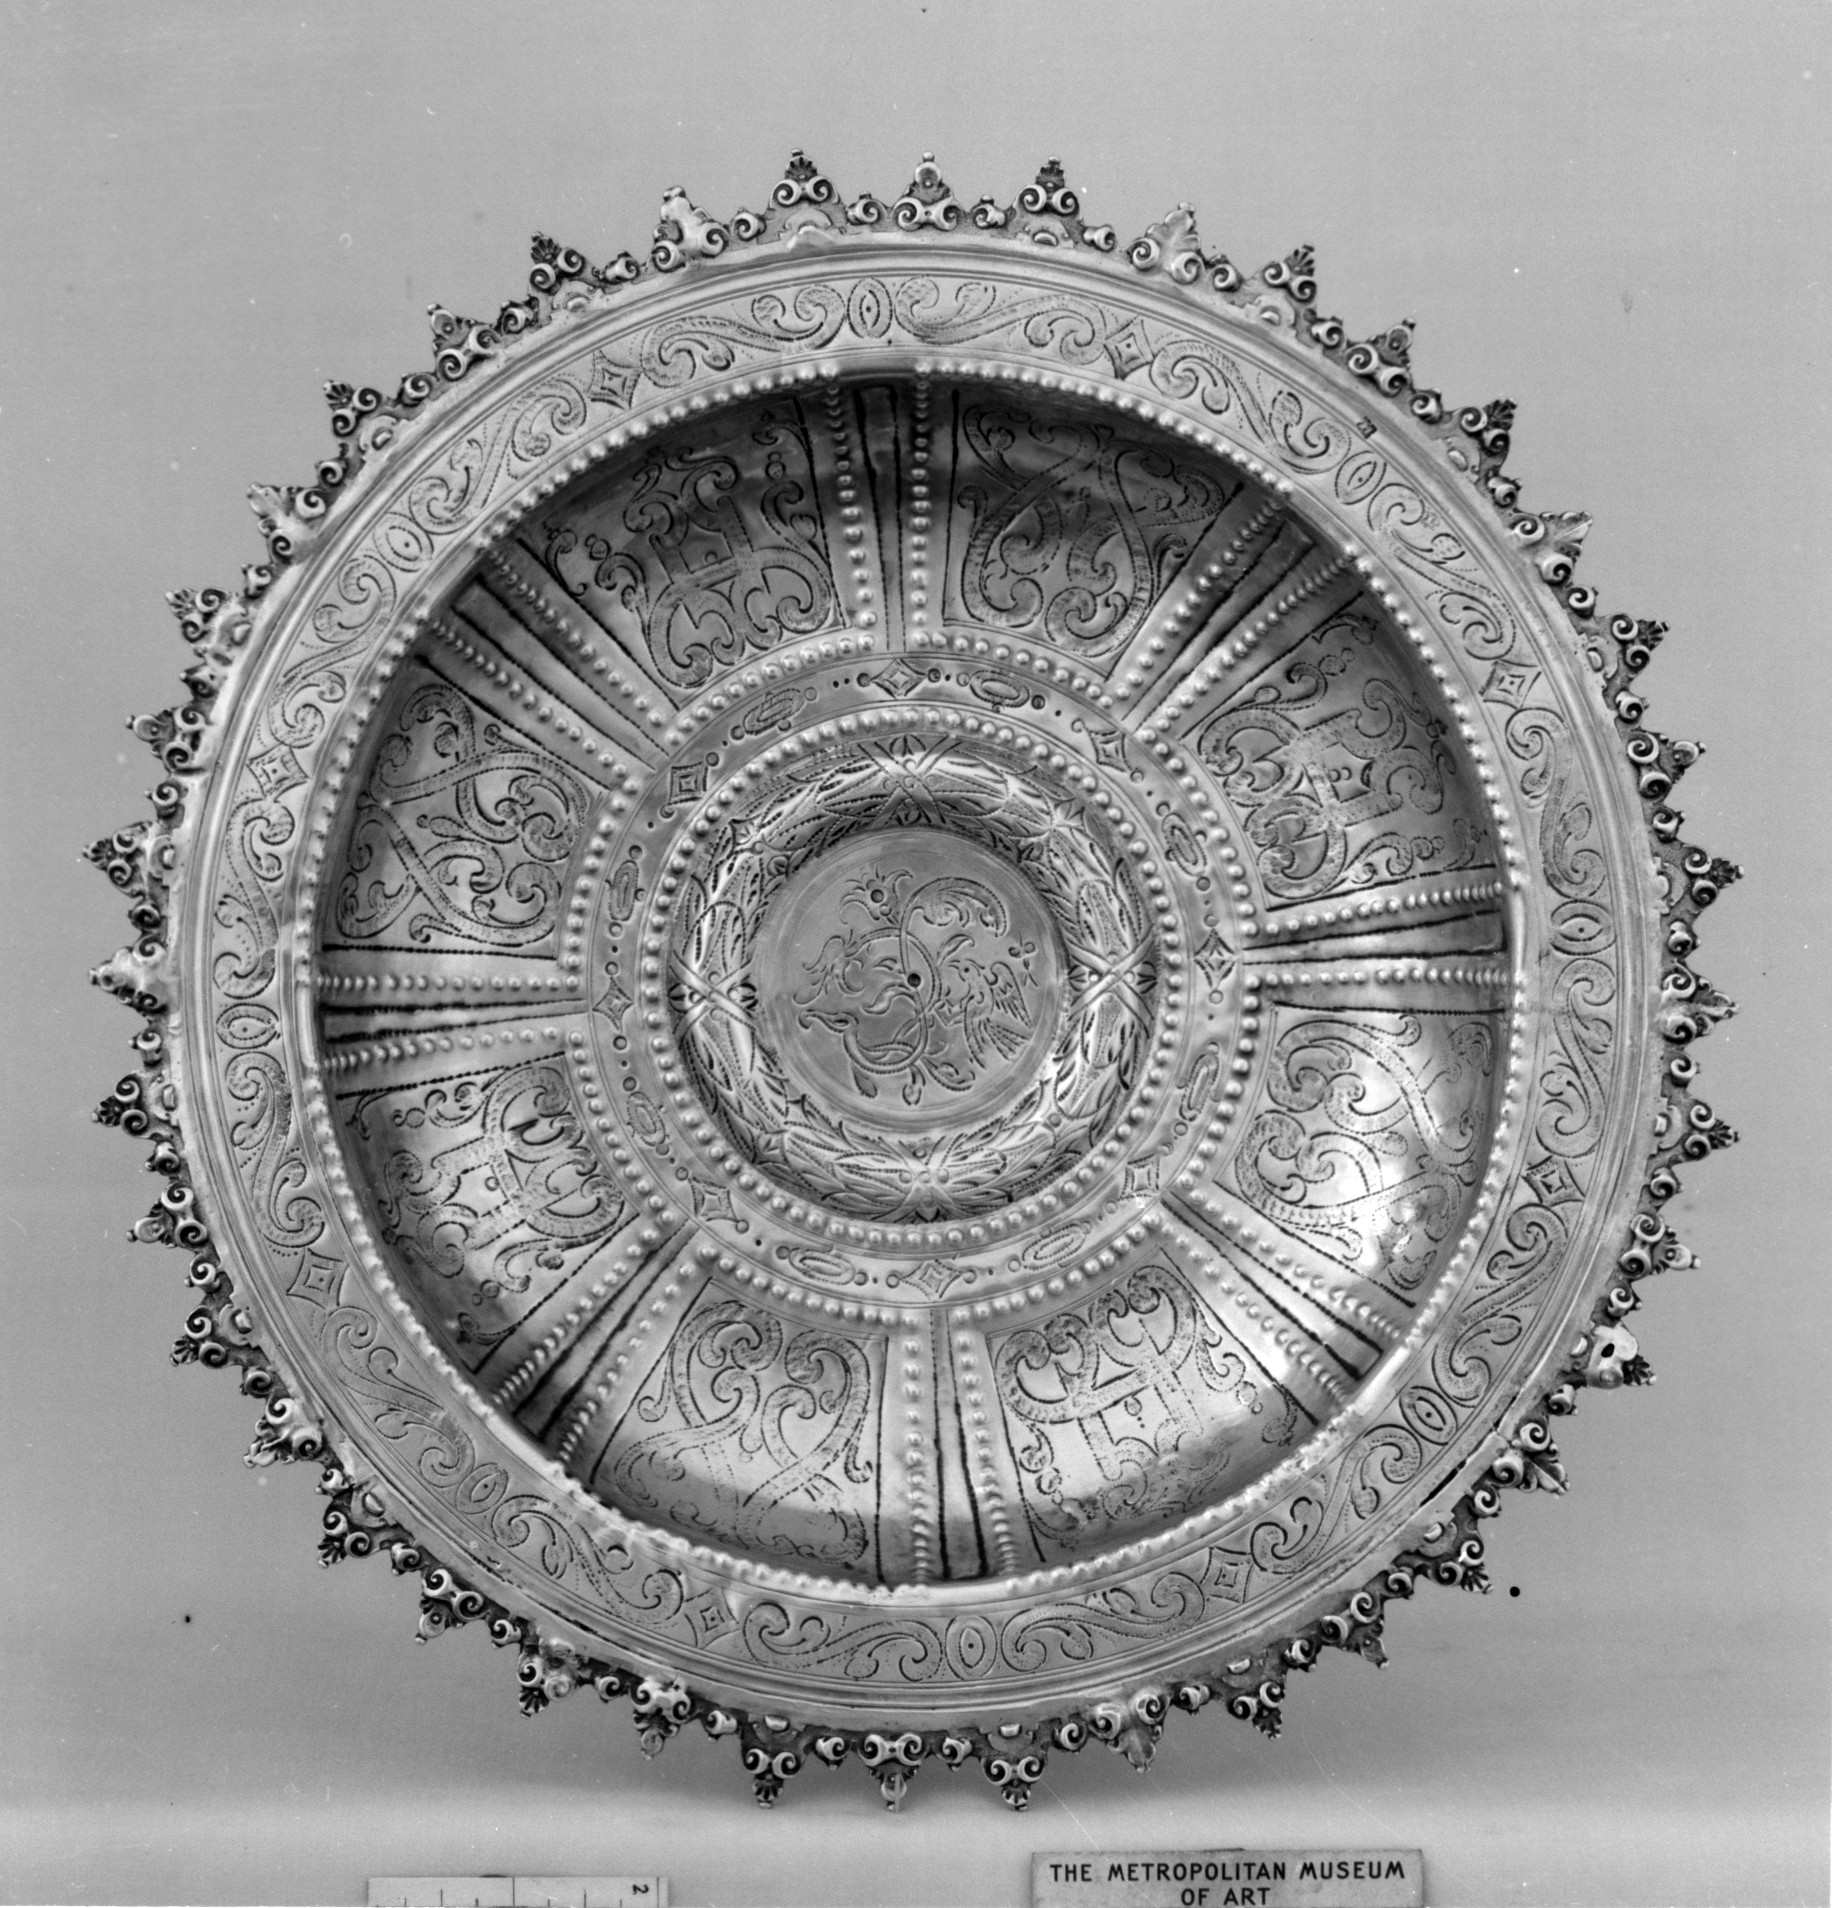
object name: dish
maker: i. l.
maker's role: maker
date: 1701-1800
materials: silver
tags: birds